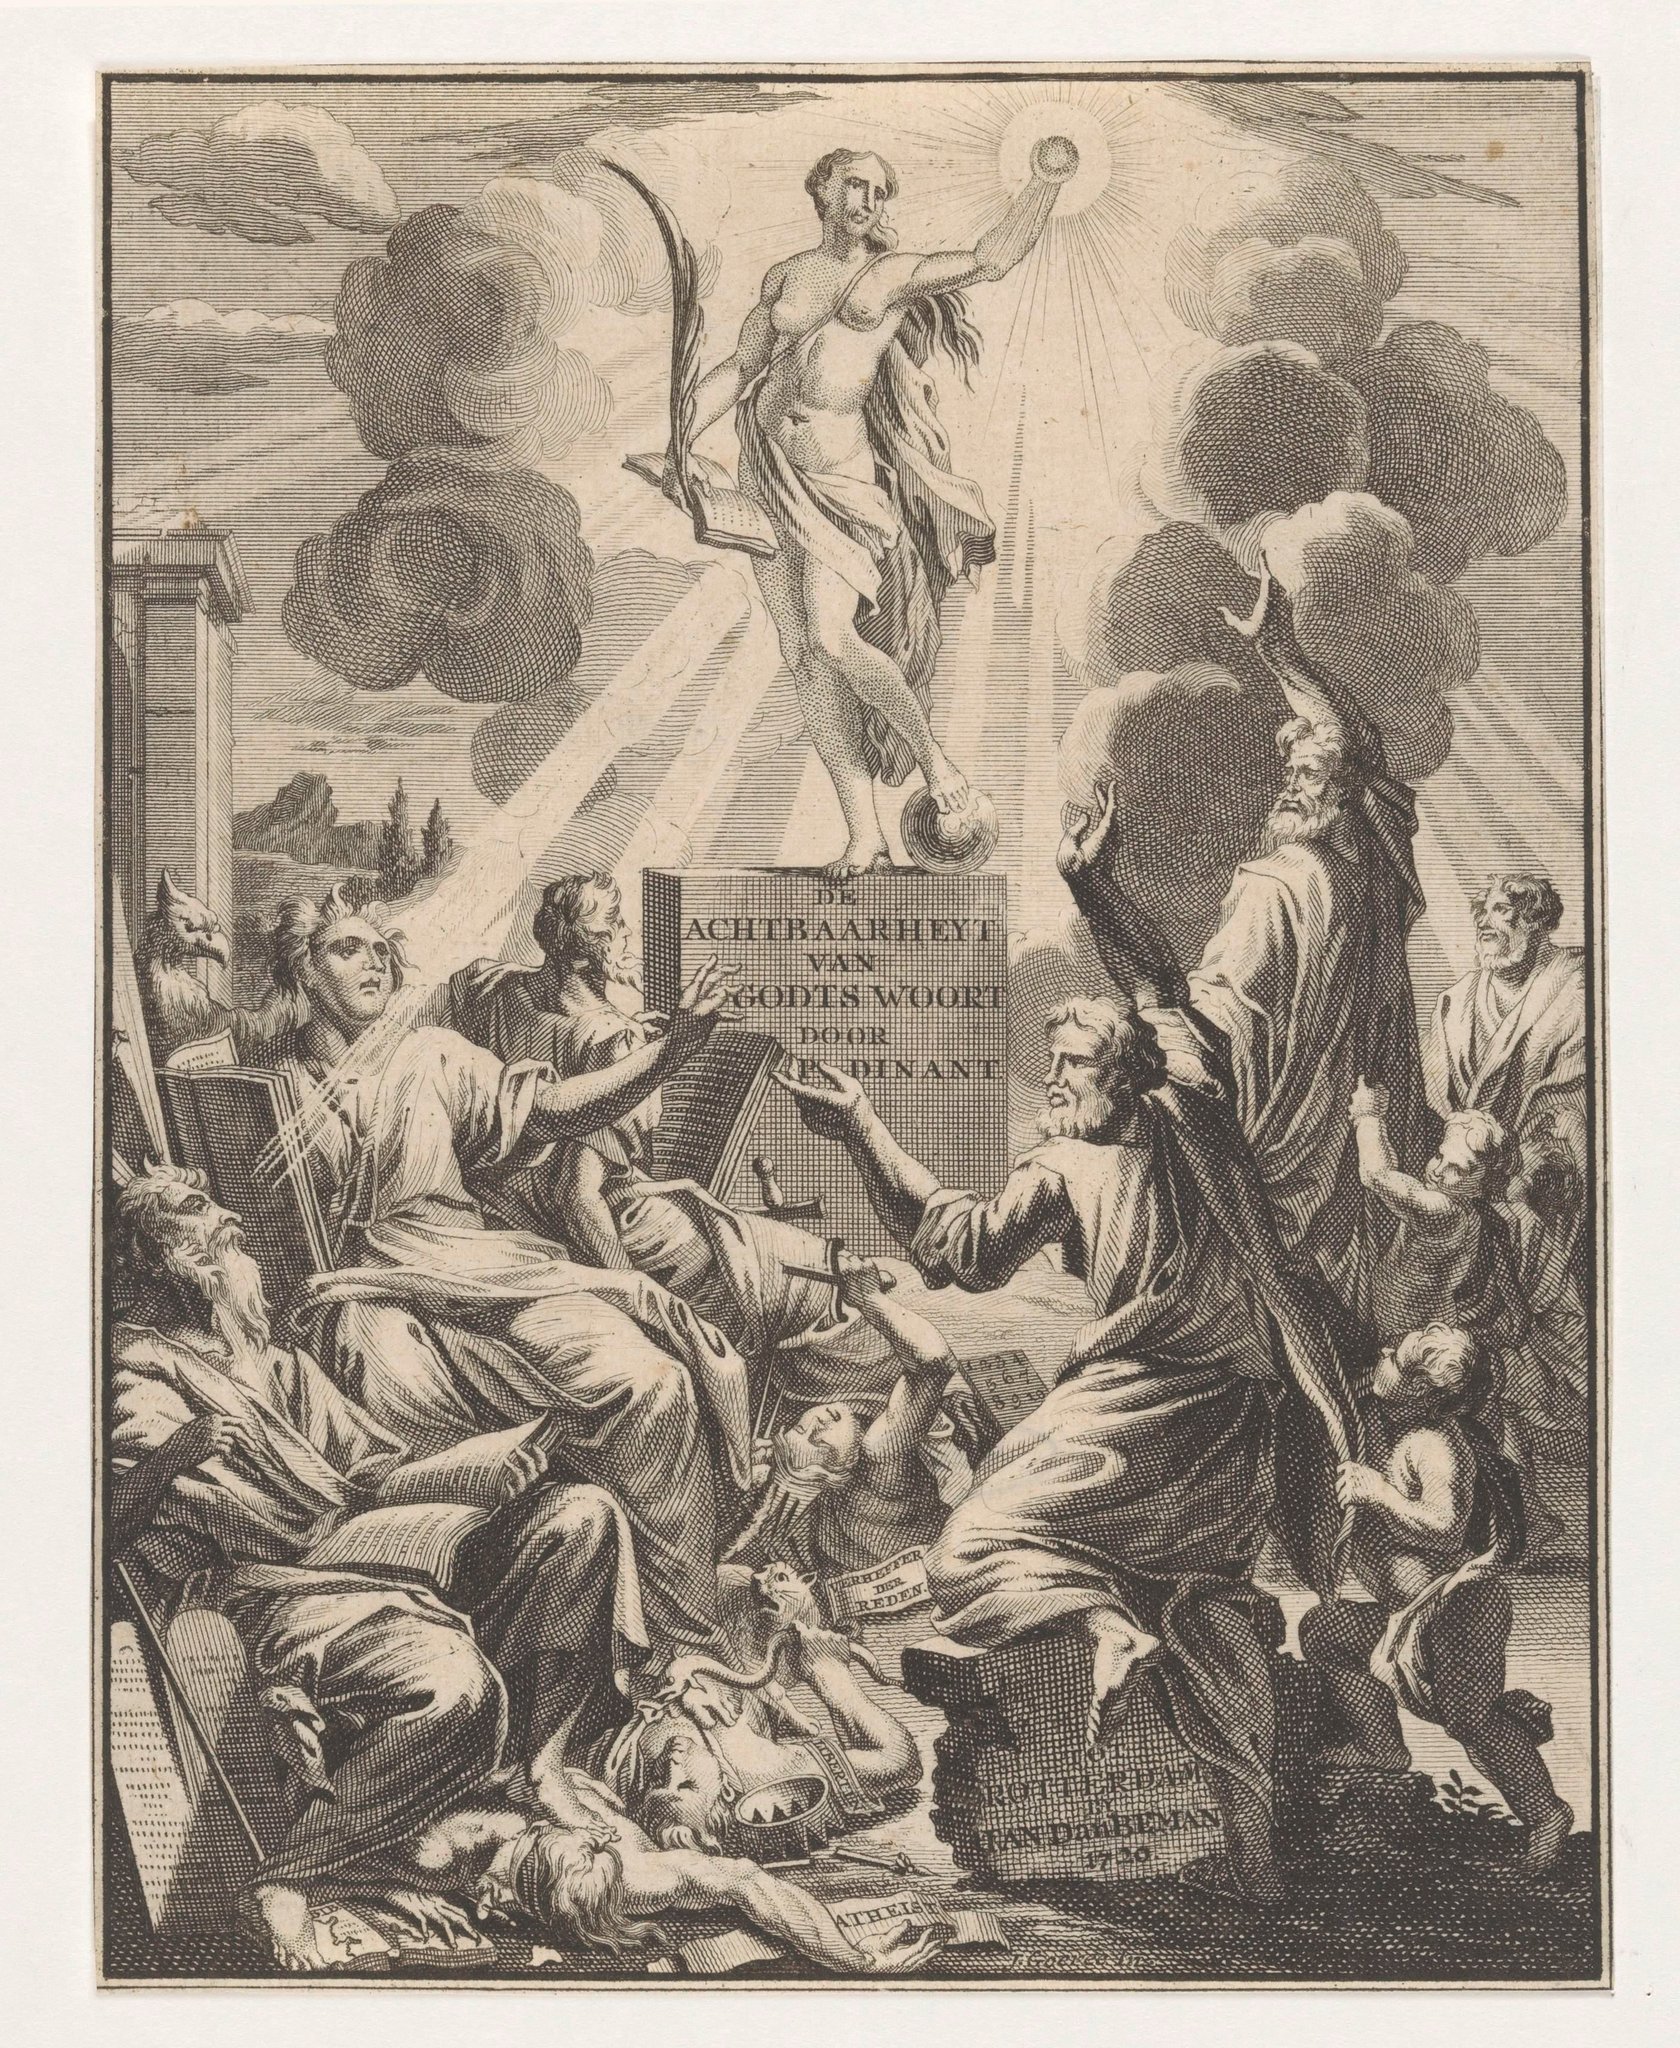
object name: titelblad, titelpagina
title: Titelpagina voor: Petrus Dinant, De achtbaarheyt van Godts woort, 1720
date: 1720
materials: paper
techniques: engraving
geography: rotterdam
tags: the apostle john the evangelist; possible attributes: book, cauldron, chalice with snake, eagle, palm, scroll, scholar, philosopher, truth; 'verità' (ripa), moses (not in biblical context); possible attributes: rays of light or horns on his head, rod, tables of the law, the apostle paul of tarsus; possible attributes: book, scroll, sword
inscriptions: collector's mark: Lugt 2228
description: De Naakte Waarheid met boek, palmtak en voet op een globe staat op een voetstuk met de boektitel. Met haar hand reikt zij naar de zon. Links kijken Paulus met zwaard, Johannes met adelaar en Mozes met staf en stenen tafelen naar haar. Met hun voeten vertrappen zij ongelovigen, hier aangeduid als atheïsten, libertijen, en rationalisten. Rechts trekken drie jongens aan de mantels van geleerden, zij willen van hen Gods woord leren.